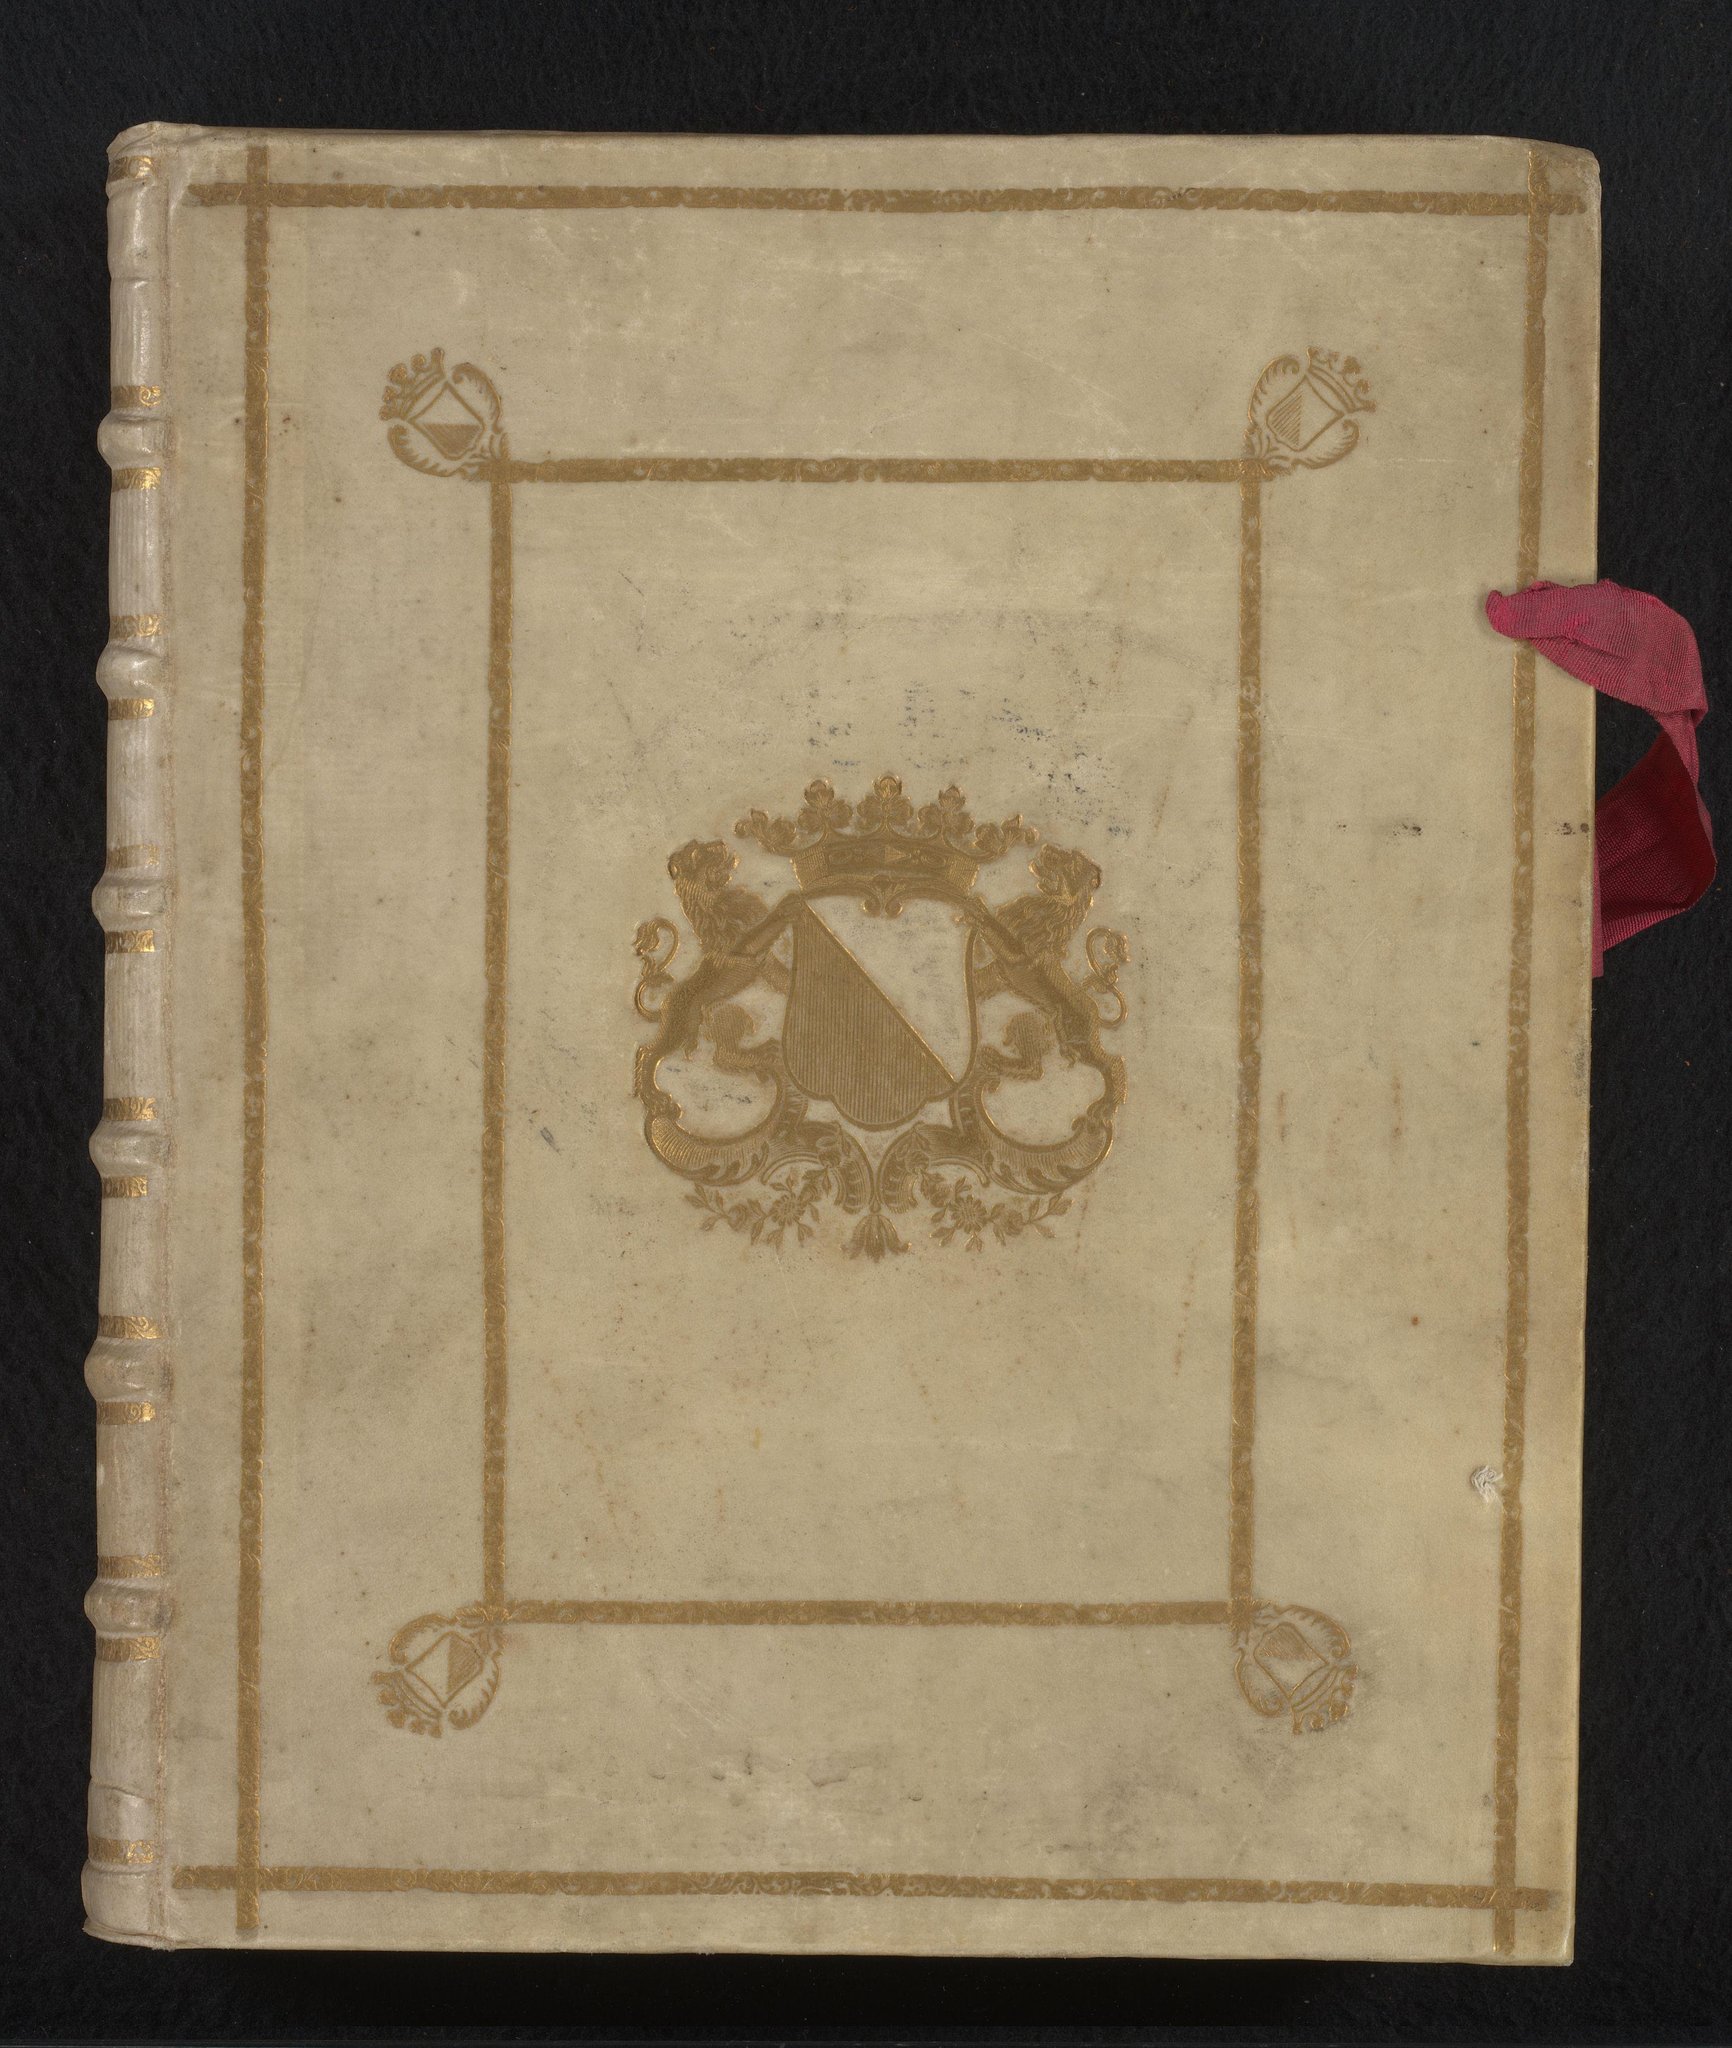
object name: book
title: Prijsband in 1781 uitgereikt aan Johan Gerard Swellengrebel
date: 1742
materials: leather, linen, paper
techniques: letterpress printing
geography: leiden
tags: utrecht, johan gerard swellengrebel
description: Prijsband in 1781 namens de Universiteit van Utrecht uitgereikt aan Johan Gerard Swellengrebel. Het boek 'Auctores Mythographi Latini' van Augustinus van Staveren in een leren band met op de voorkant het wapen van Utrecht. Met een rood lint.